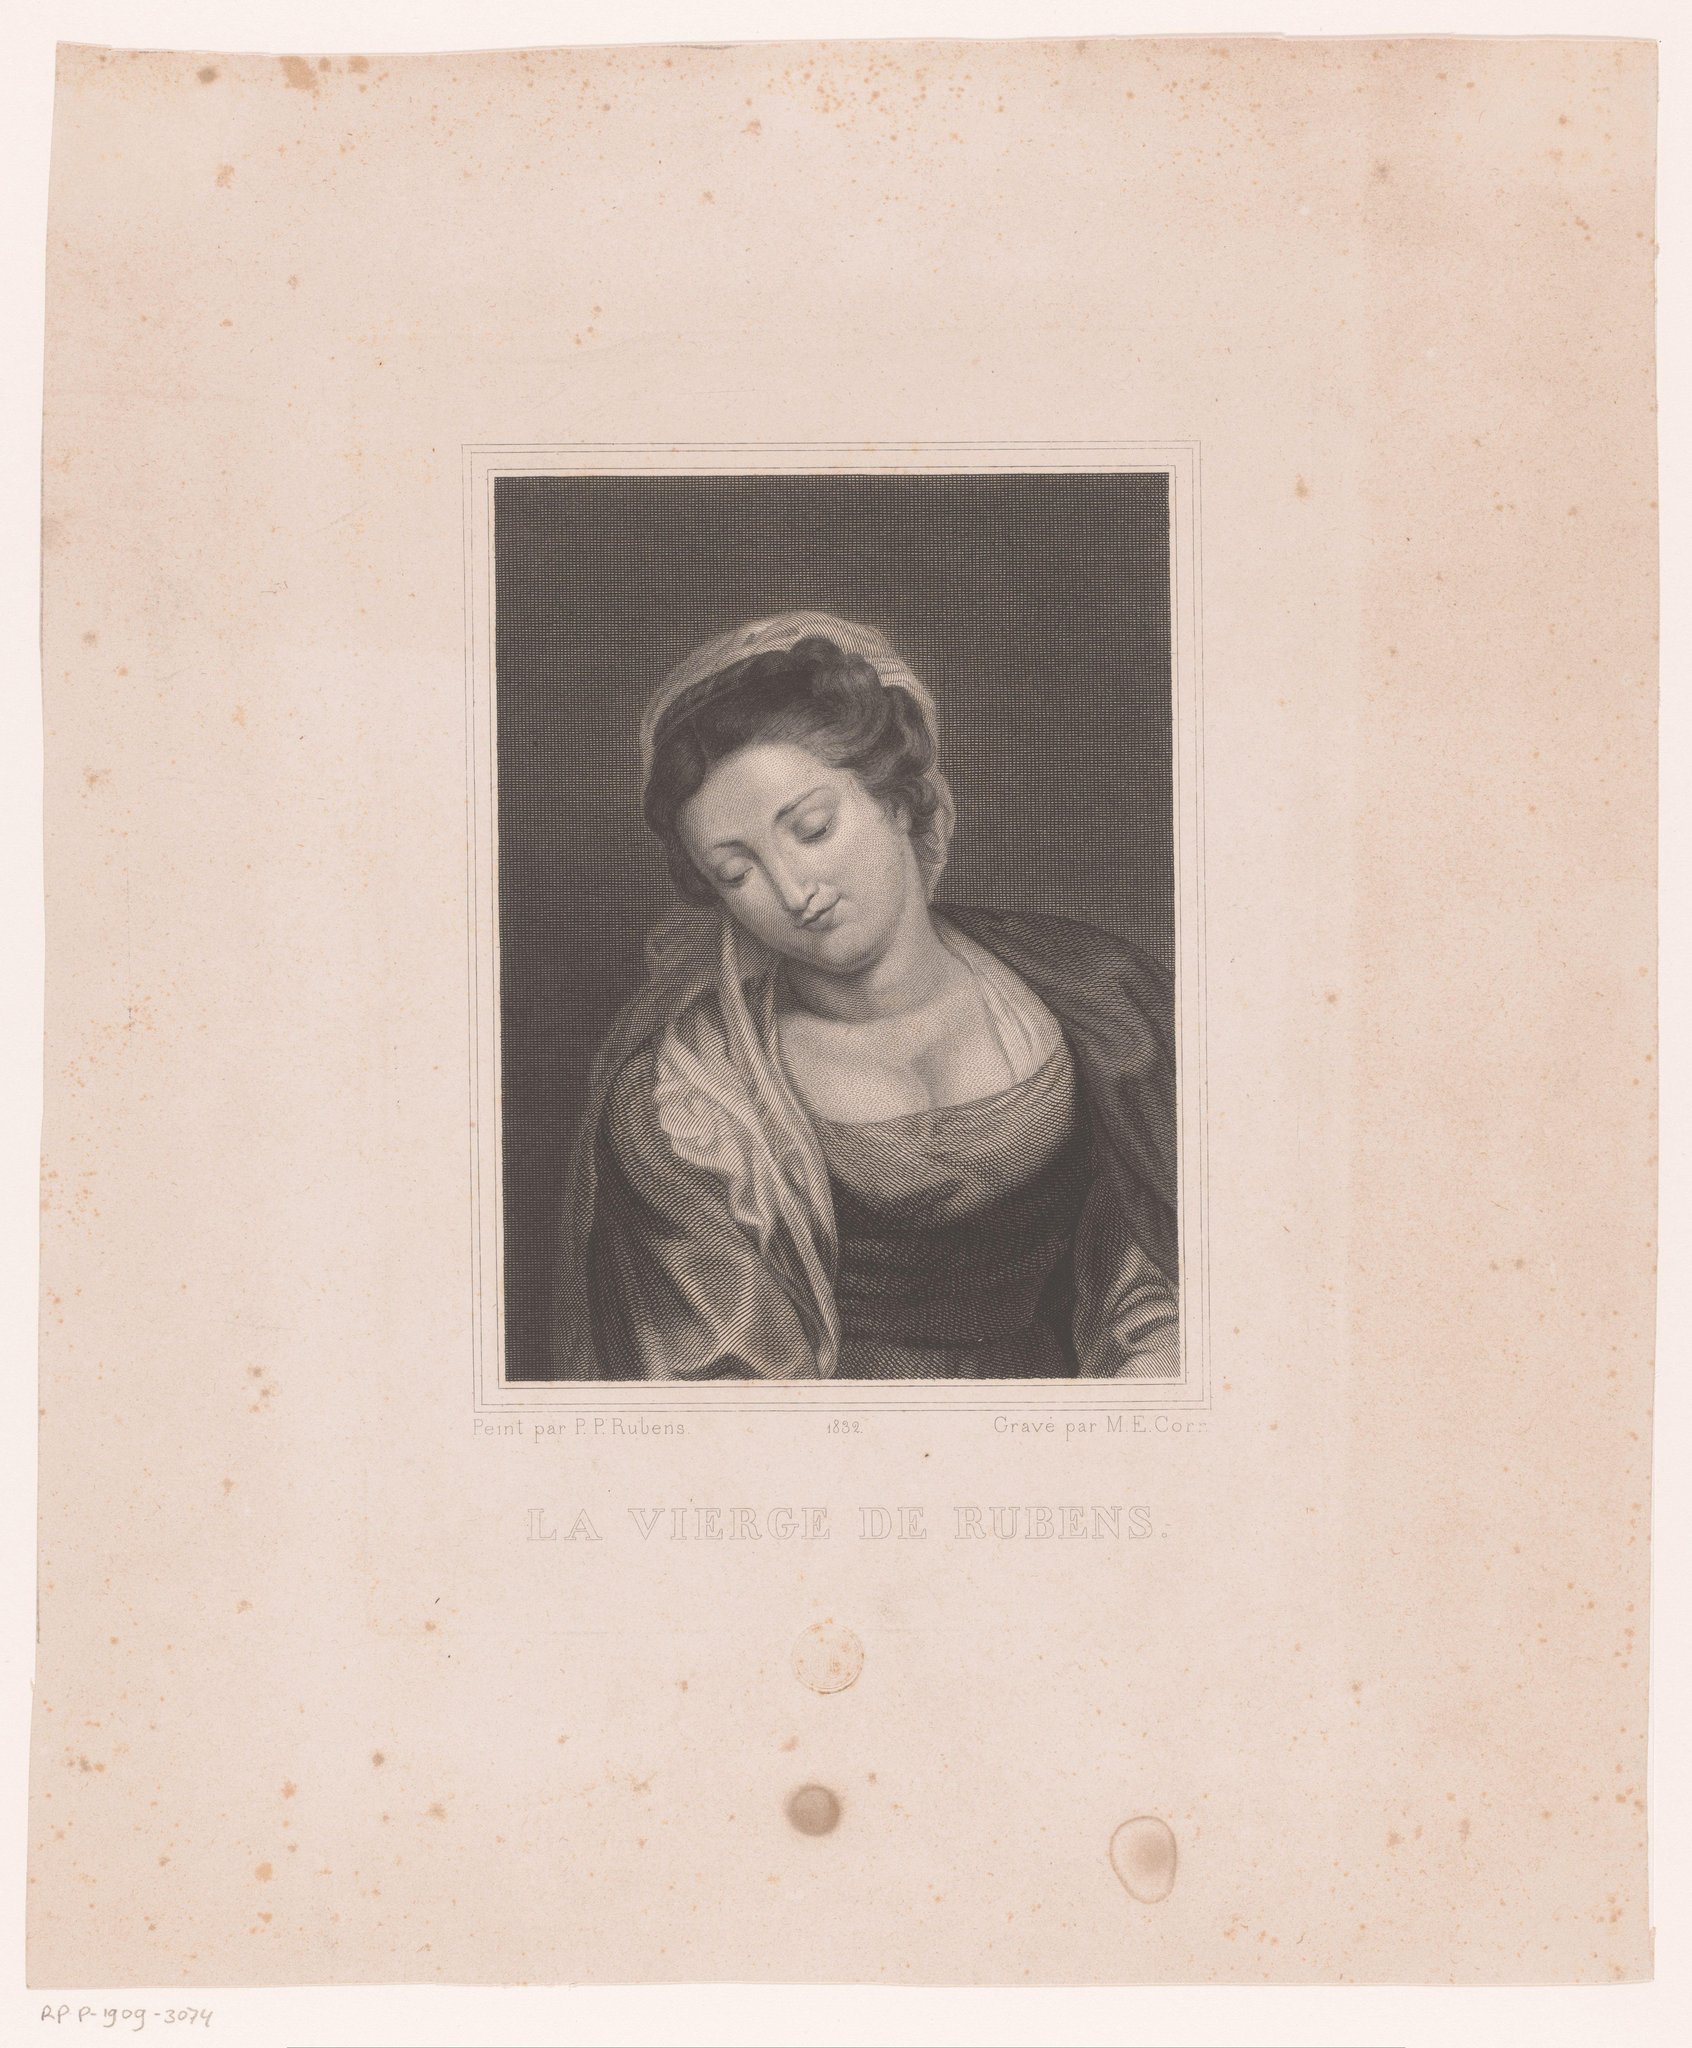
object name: print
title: Maagd Maria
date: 1832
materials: paper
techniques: engraving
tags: 'portraits' of mary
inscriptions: collector's mark: Lugt 2228, mark: ‘E.M.C’